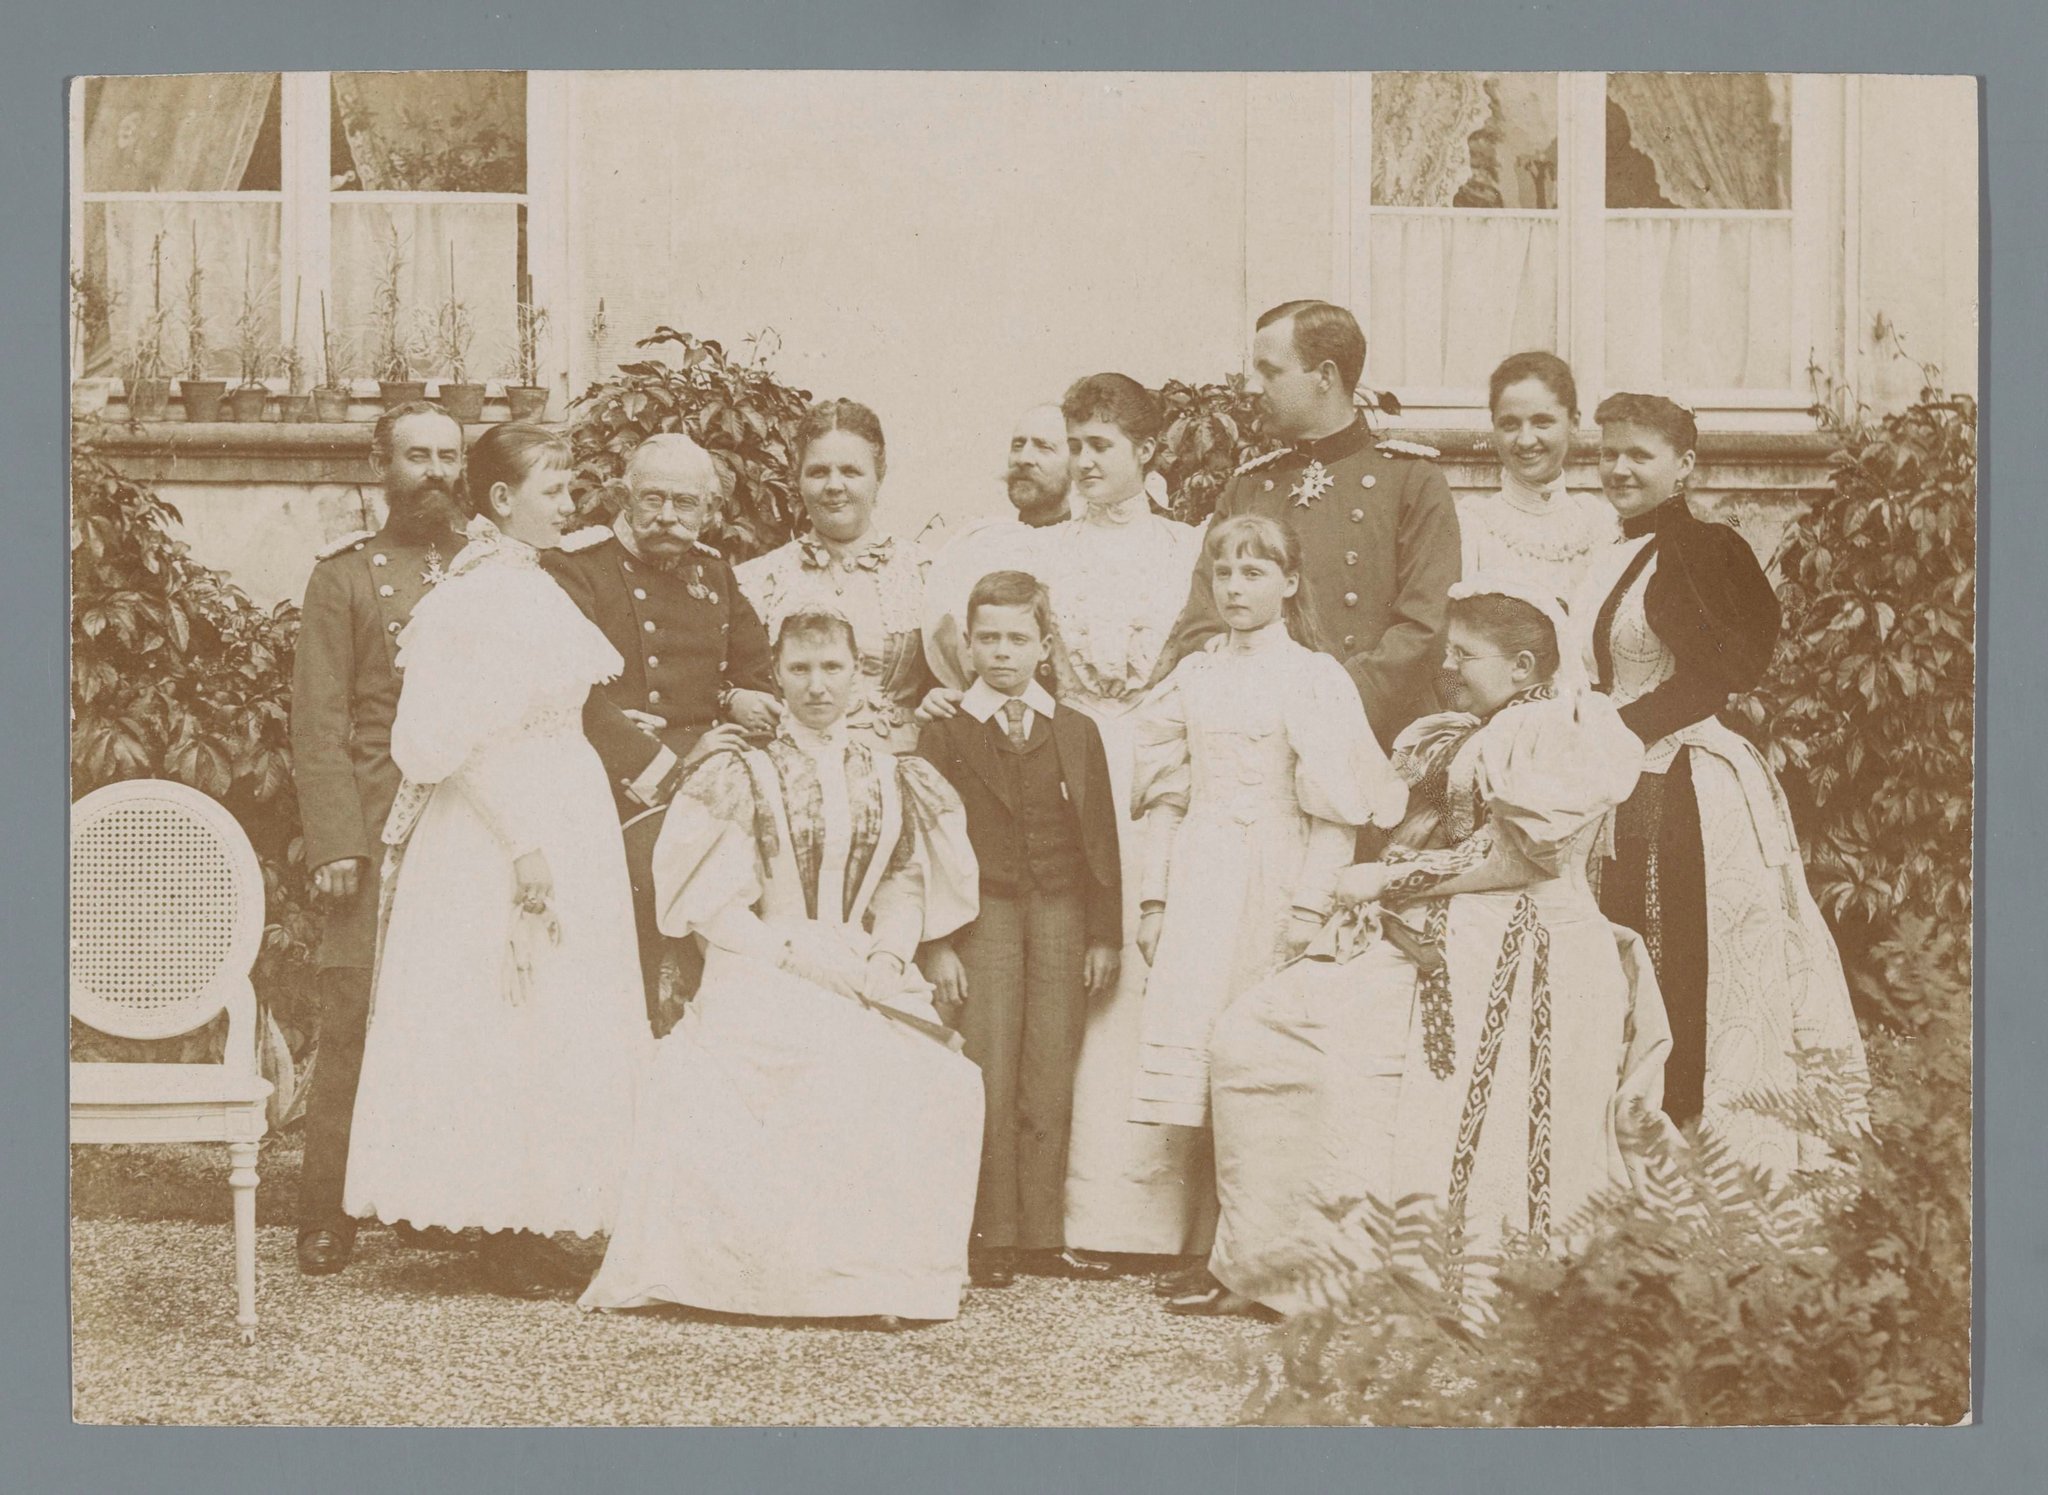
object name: photograph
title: Groepsportret van de familie van koningin-regentes Emma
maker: Anonymous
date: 1896-1897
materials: photographic support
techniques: gelatin silver print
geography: germany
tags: the hague, wilhelmina of the netherlands, emma (queen consort of the netherlands), family of the sovereign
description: Koningin Wilhelmina staand links, daarnaast George Victor van Waldeck-Pyrmont en Pauline van Waldeck-Pyrmont. Links zittend koningin-regentes Emma met rechts achter haar Helena van Waldeck-Pyrmont.